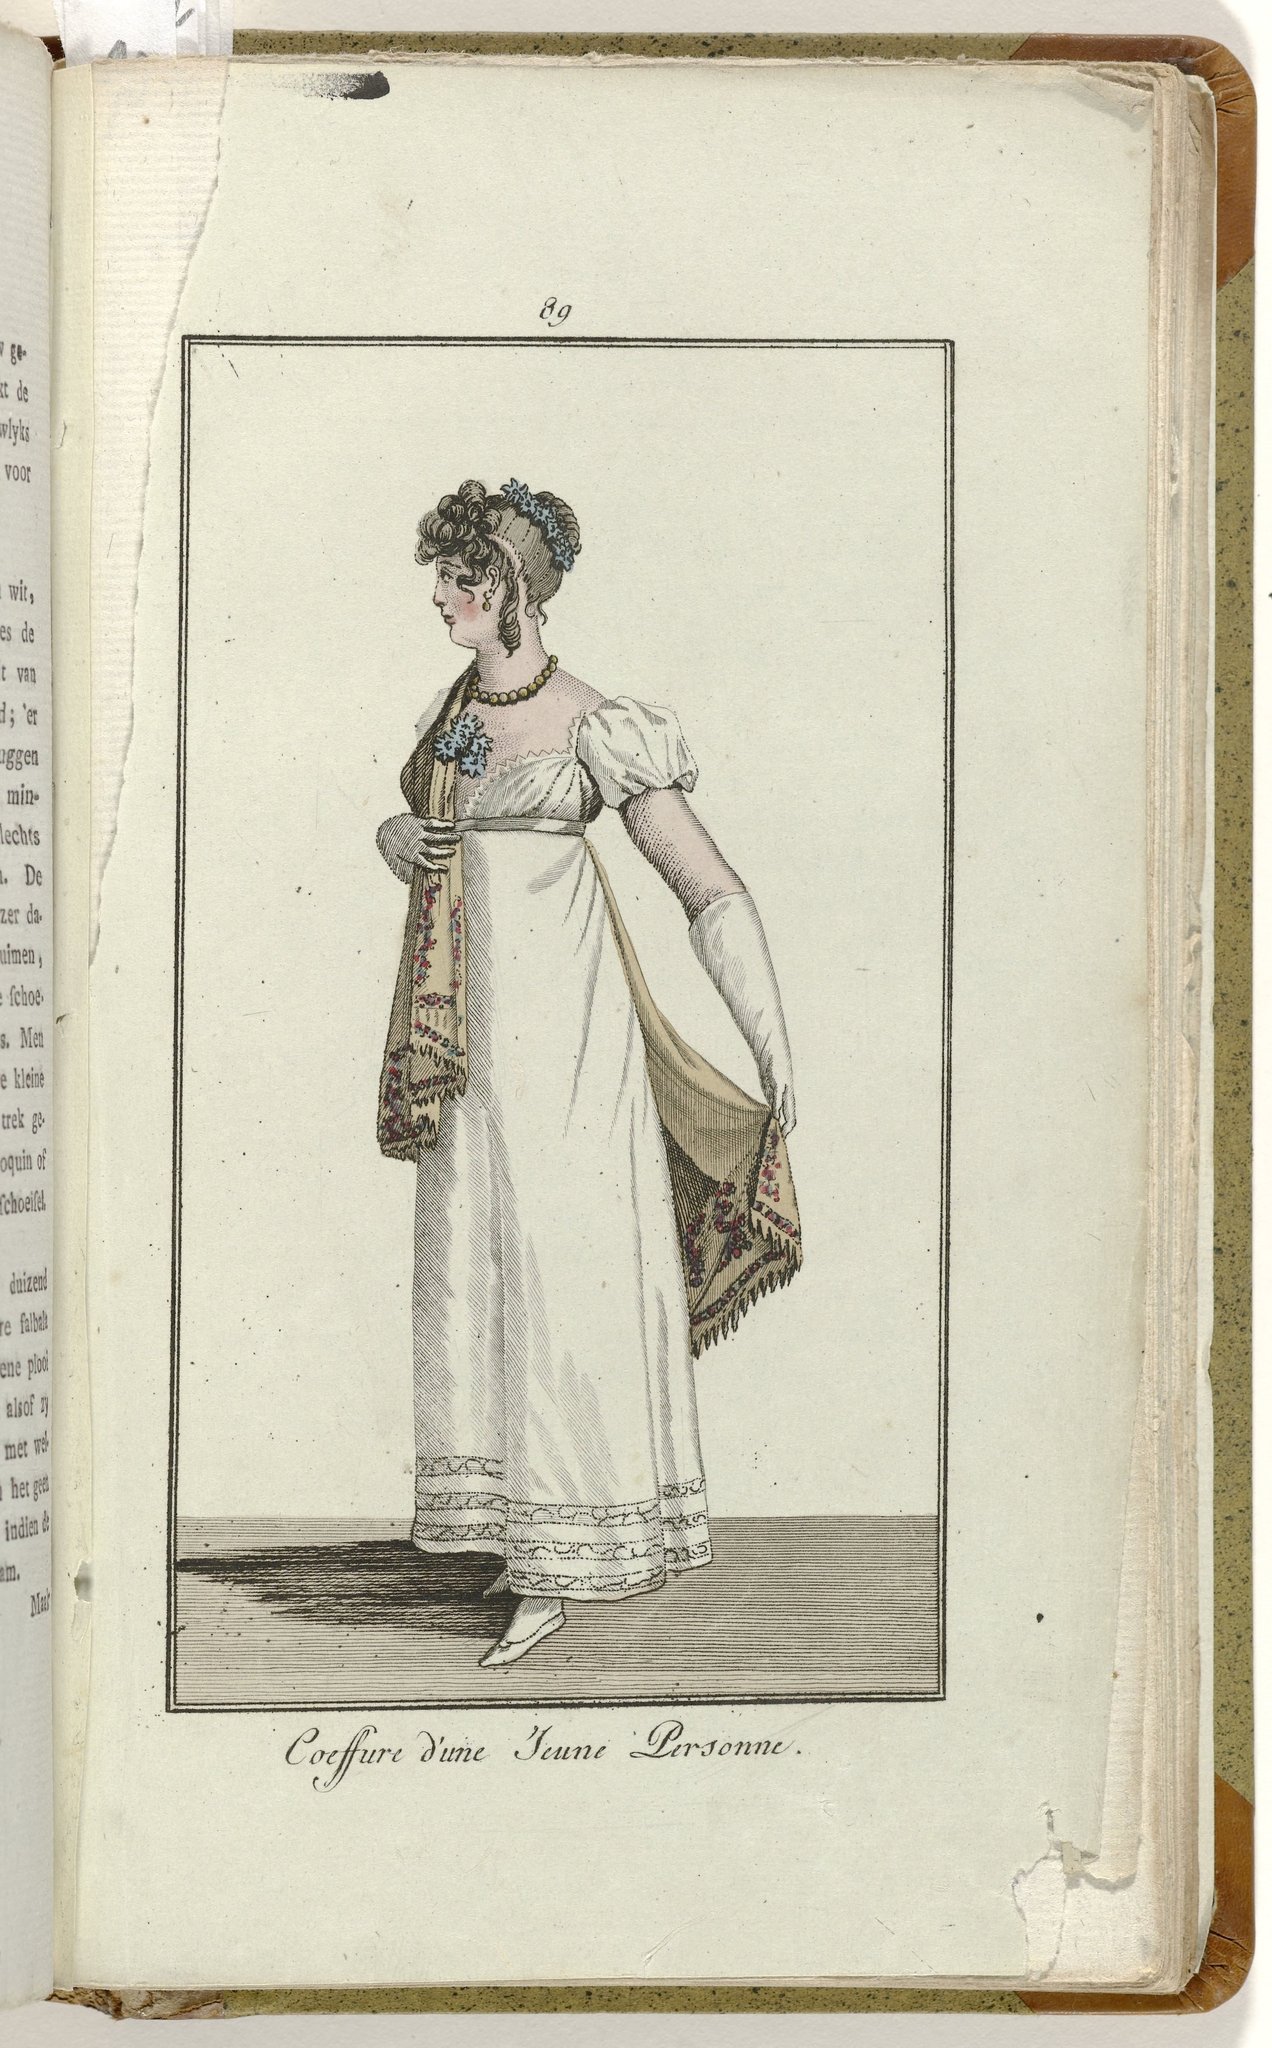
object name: magazine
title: Elegantia, of tijdschrift van mode, luxe en smaak voor dames, September 1809, No. 89: Coeffure d'une Jeune Personne.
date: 1809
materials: paper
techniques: engraving, hand coloring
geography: amsterdam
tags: corsage (+ women's clothes), gloves, mittens (long gloves) (+ women's clothes), clothing for the upper part of the body (shawl) (+ women's clothes), styles of hairdress - aa - ~ women, fashion plates, dress, gown (+ women's clothes), necklace (+ women's clothes)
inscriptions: caption: ‘Coeffure d'une Jeune Personne.’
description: Volgens de begeleidende tekst (p. 288): Japon van katoenbatist (percale). Kapsel met dezelfde bloemen als het boeket. Sjaal van kasjmier. Volgens het onderschrift heeft zij een kapsel geschikt voor een jong persoon. Prent uit het modetijdschrift Elegantia, of tijdschrift van mode, luxe en smaak voor dames 1807-1814 (onderbroken door de periode 1811-1813). De prent is een kopie naar 25 septembre 1809, No. 1006, uit het Franse modetijdschrift Journal des Dames et des Modes ( 1797-1839).